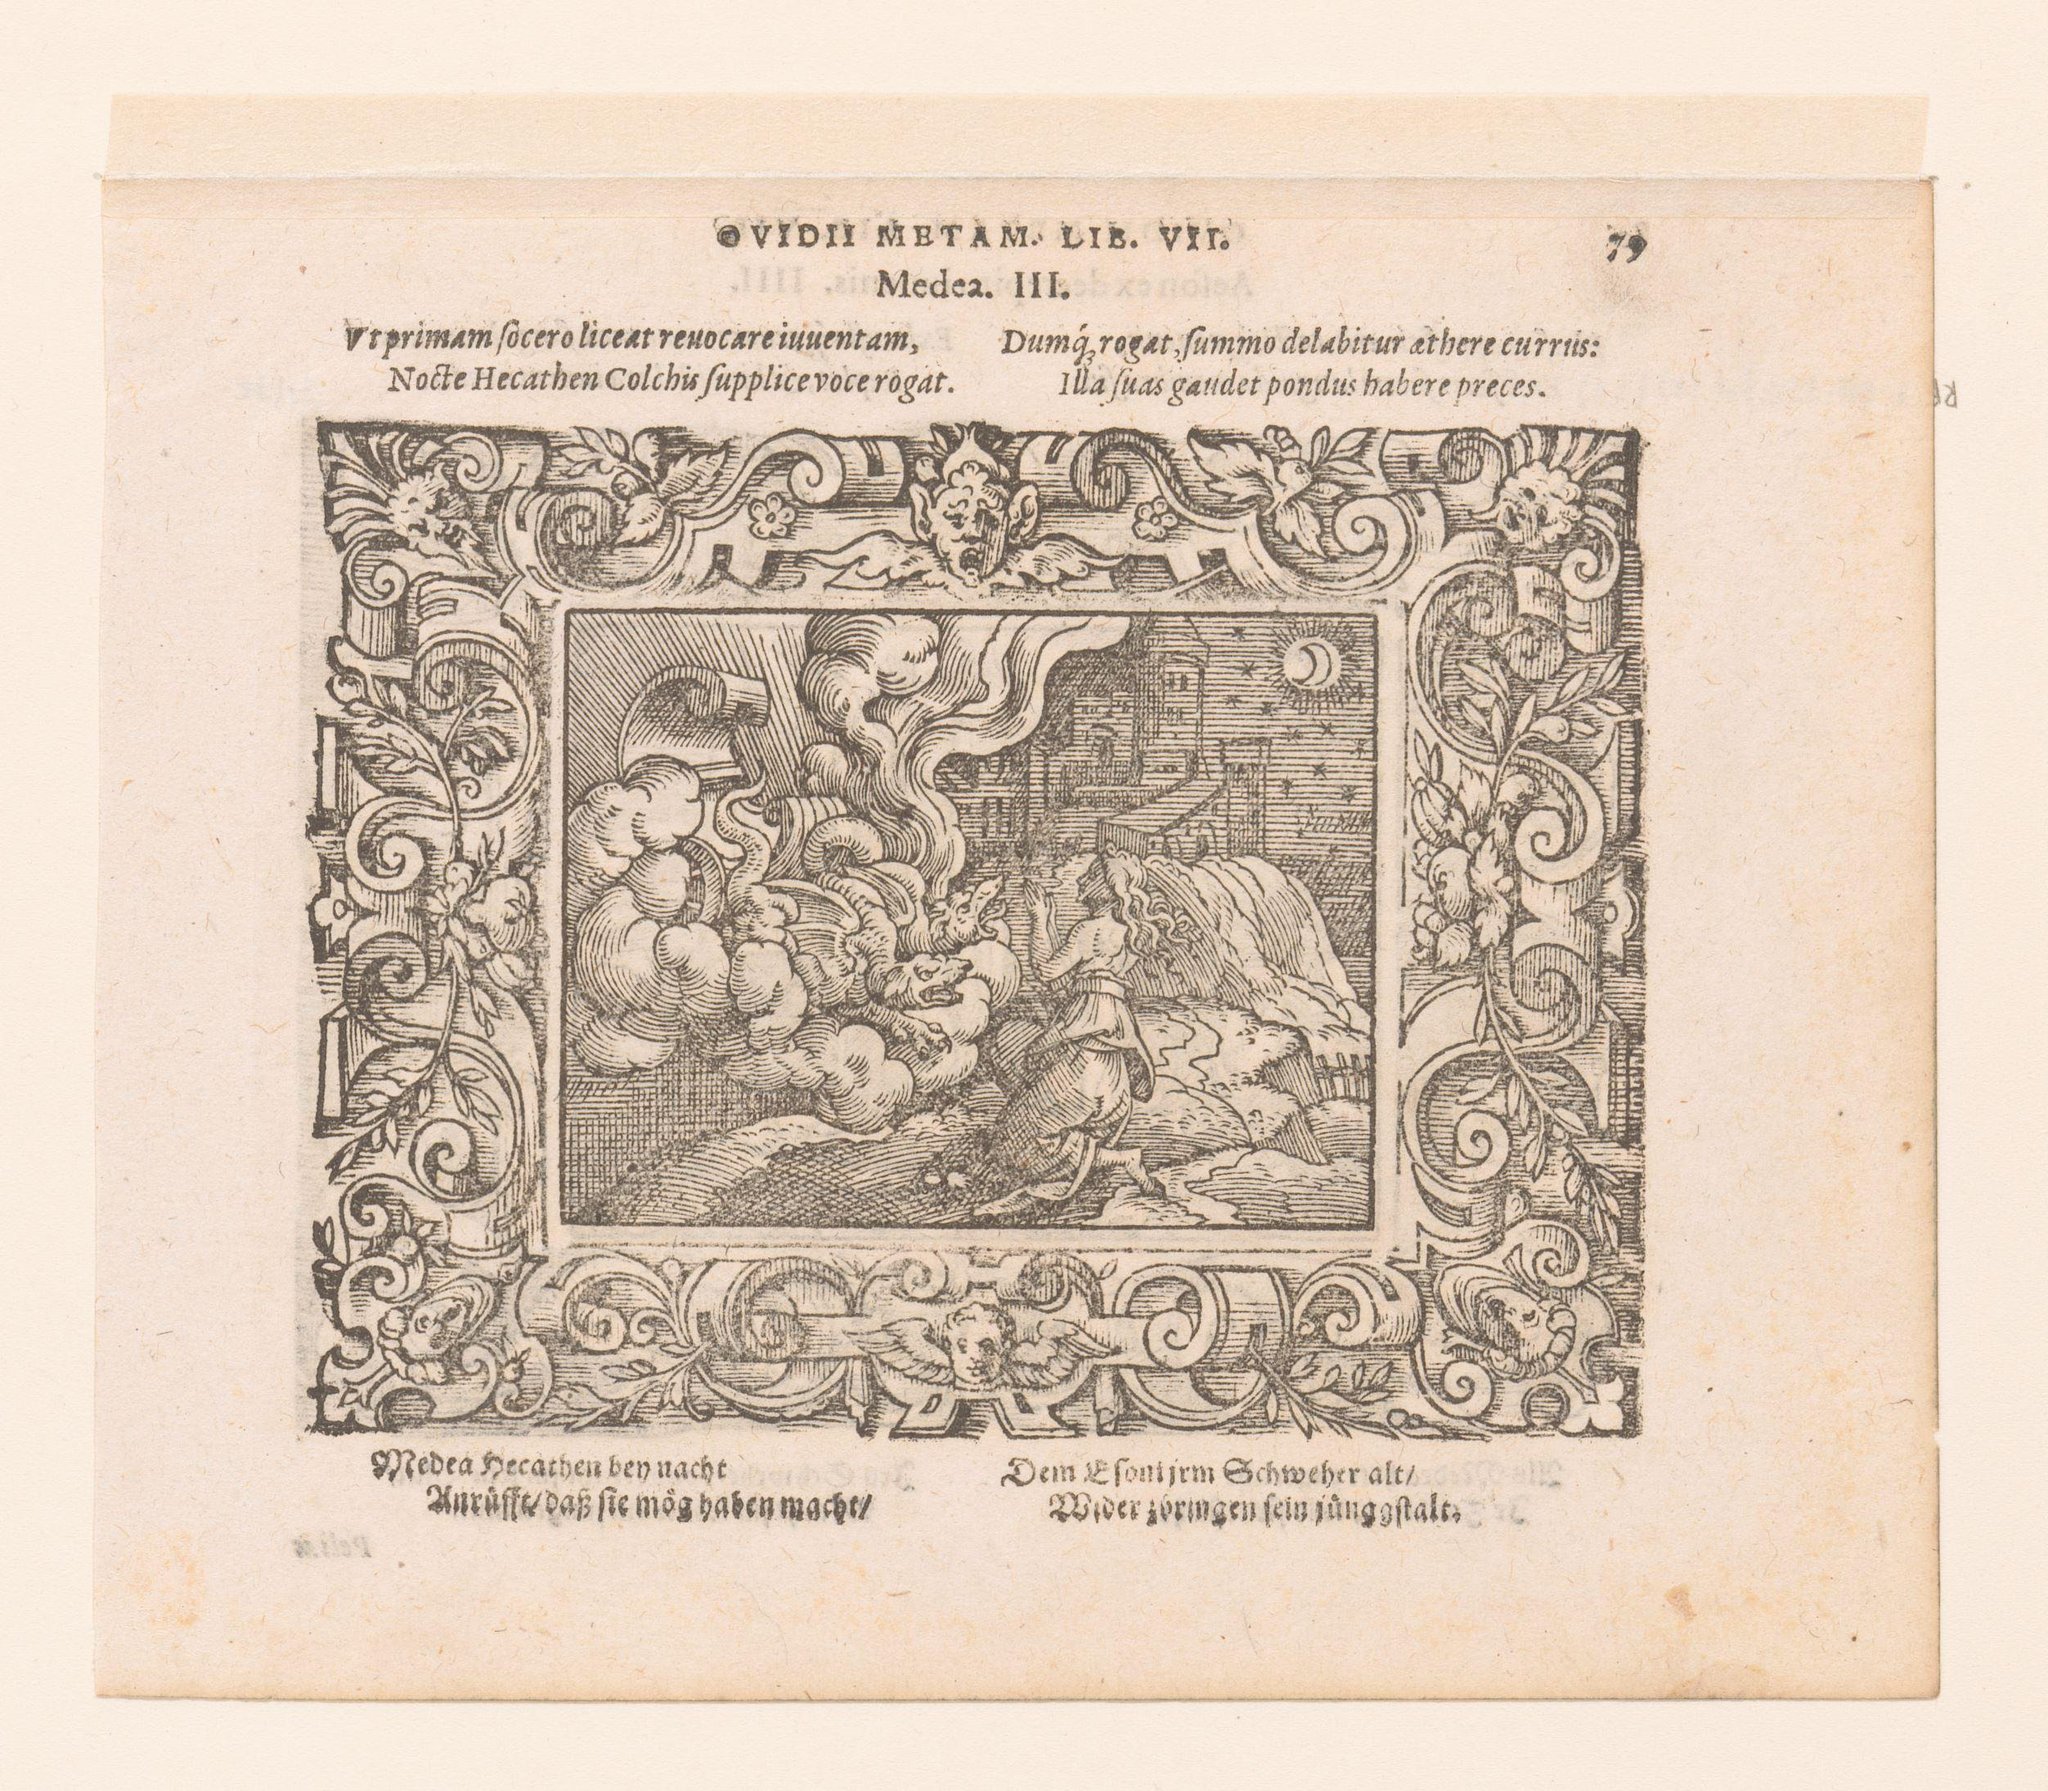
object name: print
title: Medea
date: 1569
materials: paper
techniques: letterpress printing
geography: frankfurt am main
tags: medea prays alone in the night; her chariot, drawn by winged dragons, is sent to enable her to pick magic herbs, scrollwork, strapwork ~ ornament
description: Illustratie bij de Metamorfosen van Ovidius, afkomstig uit de publicatie: Posthius, Johannes. Tetrasticha in Ovidii metam. Frankfurt am Main: Georg Rab en Sigmund Feyerabend en erven Weigand Han, 1569. De voorstellingen en ornamentranden van deze boekillustraties zijn van twee aparte blokken gedrukt. Beide werden afzonderlijk van elkaar ook gebruikt voor andere publicaties, en de ornamentranden werden eveneens binnen deze publicatie meerdere keren gebruikt.